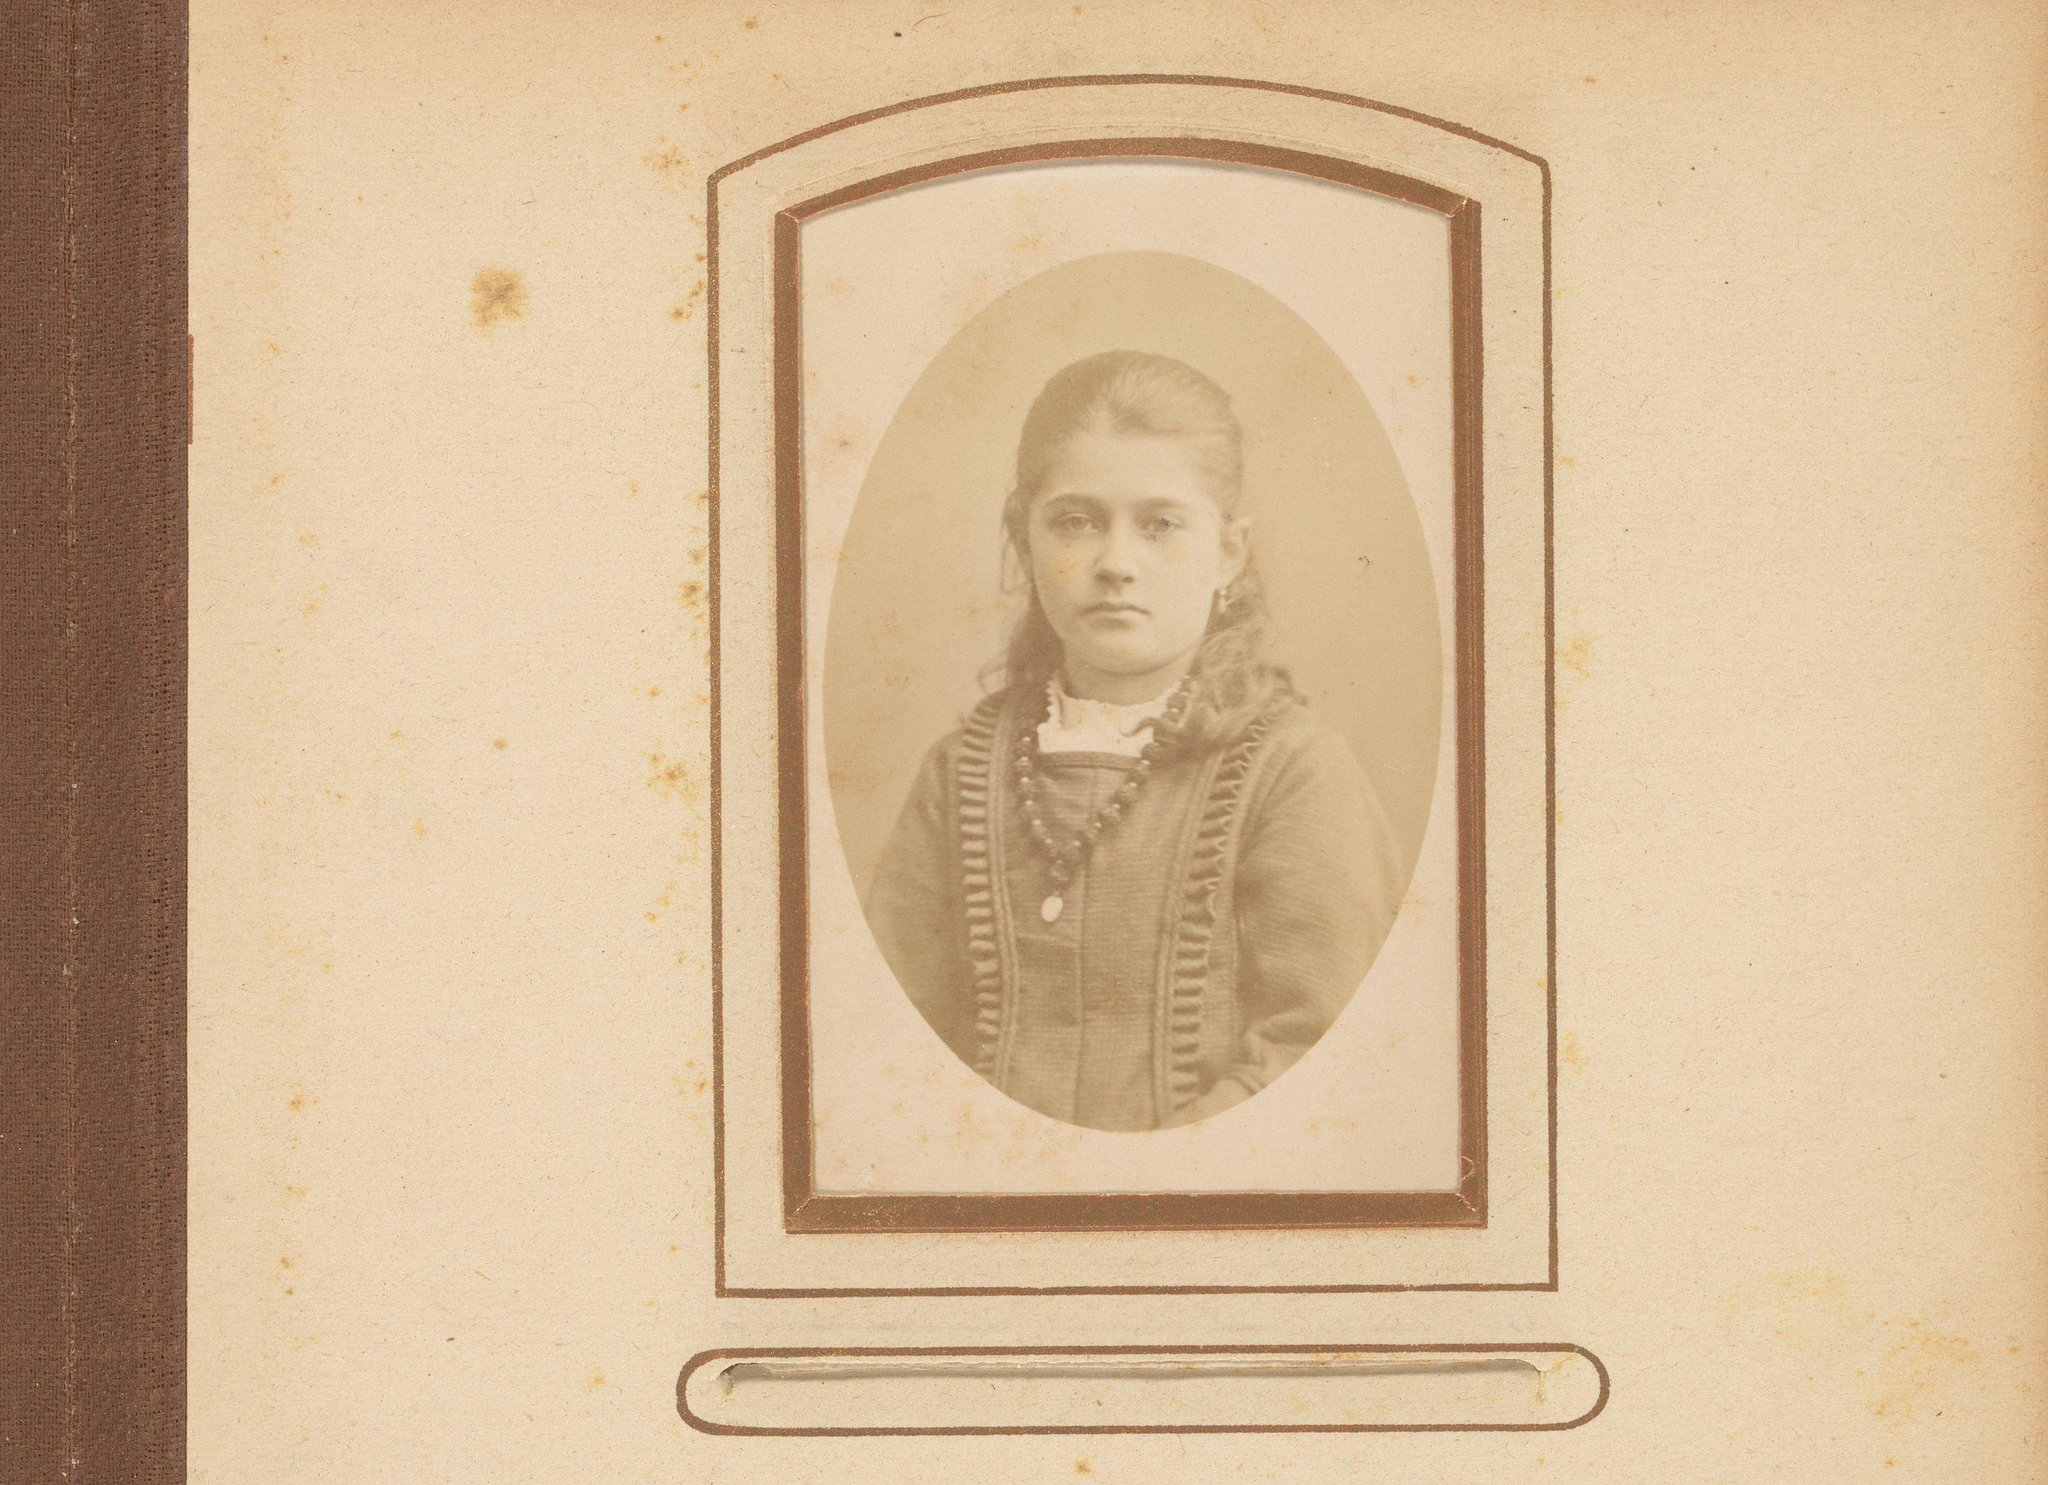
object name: photograph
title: Portret van een meisje met ketting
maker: max büttinghausen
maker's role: fotograaf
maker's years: 1847-1906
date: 1877-1906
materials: cardboard, photographic support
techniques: albumen print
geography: netherlands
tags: girl (child between toddler and youth)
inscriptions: inscription: ‘Amsterdam 1877/ M. Büttinghausen/ Photografisch artistisch Atelier/ Singel b/d Torensteeg G.133/ Amsterdam/ Catharijne Singel L.39.G/ Utrecht’, annotation: ‘[1 fout]’